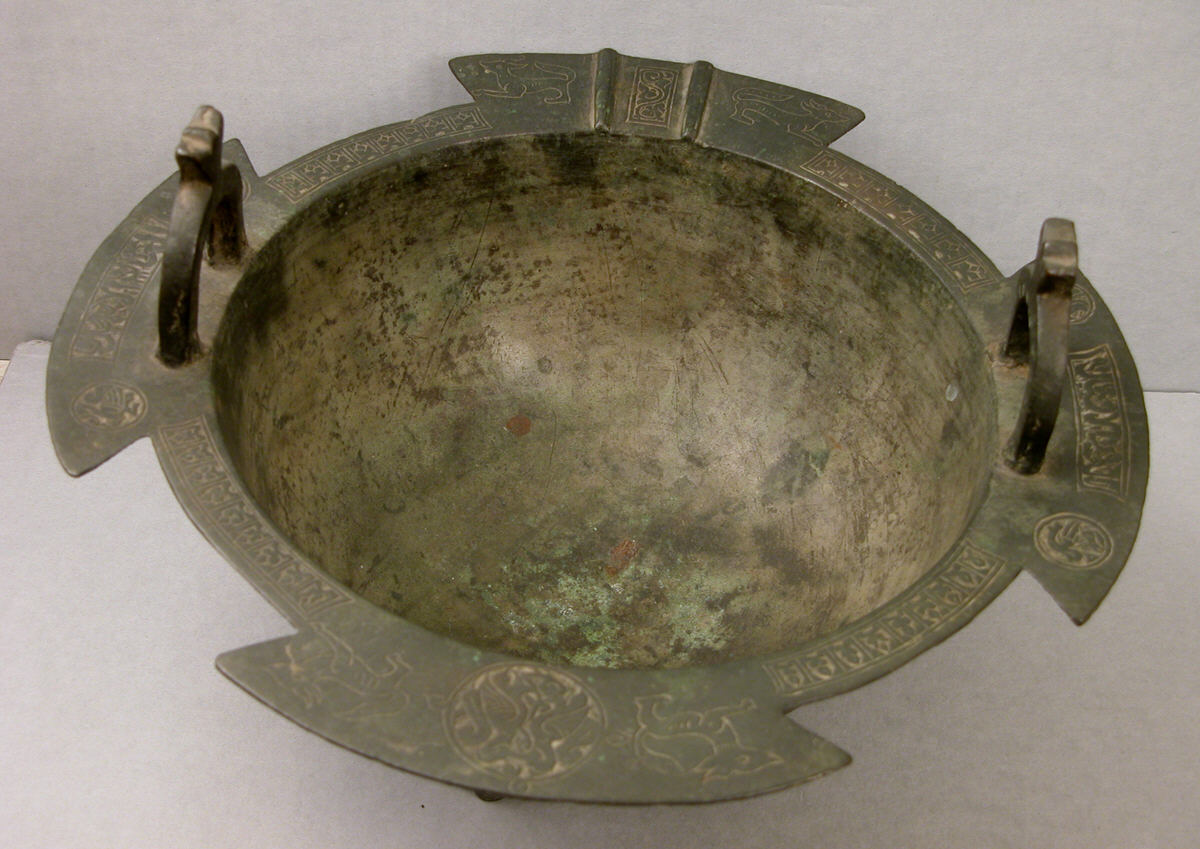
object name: cauldron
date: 1351-1400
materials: brass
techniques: casting, incising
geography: caucasus